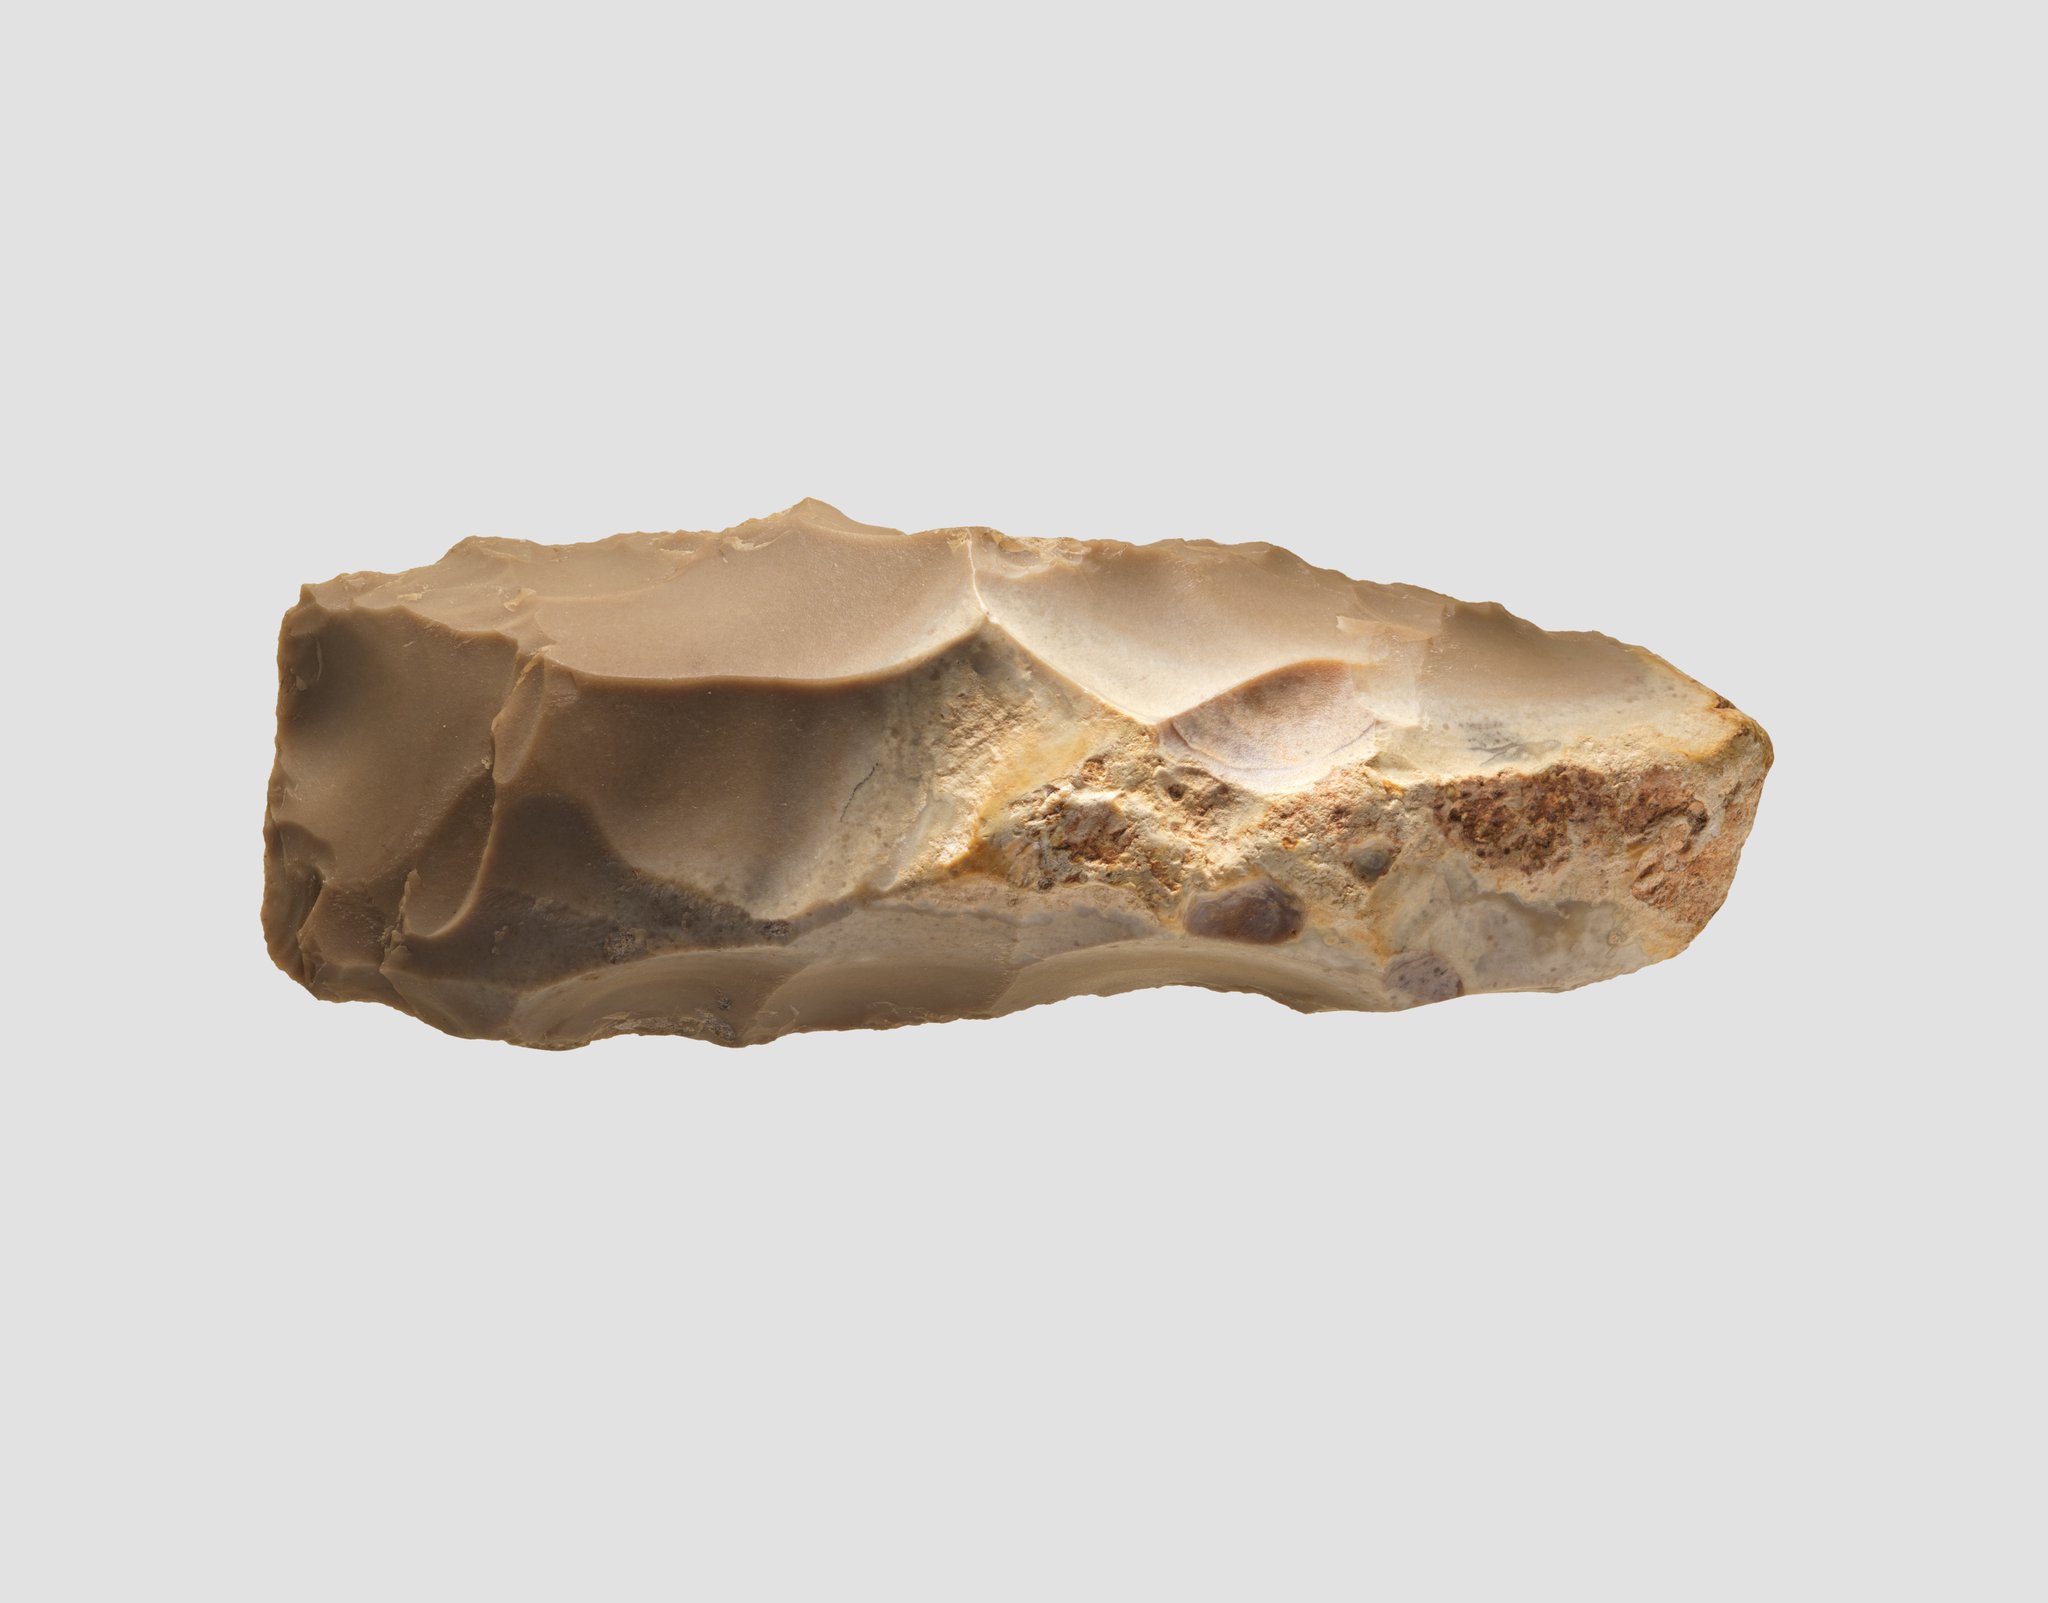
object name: chisel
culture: ghassulian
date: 4600-3600 BCE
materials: stone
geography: levant